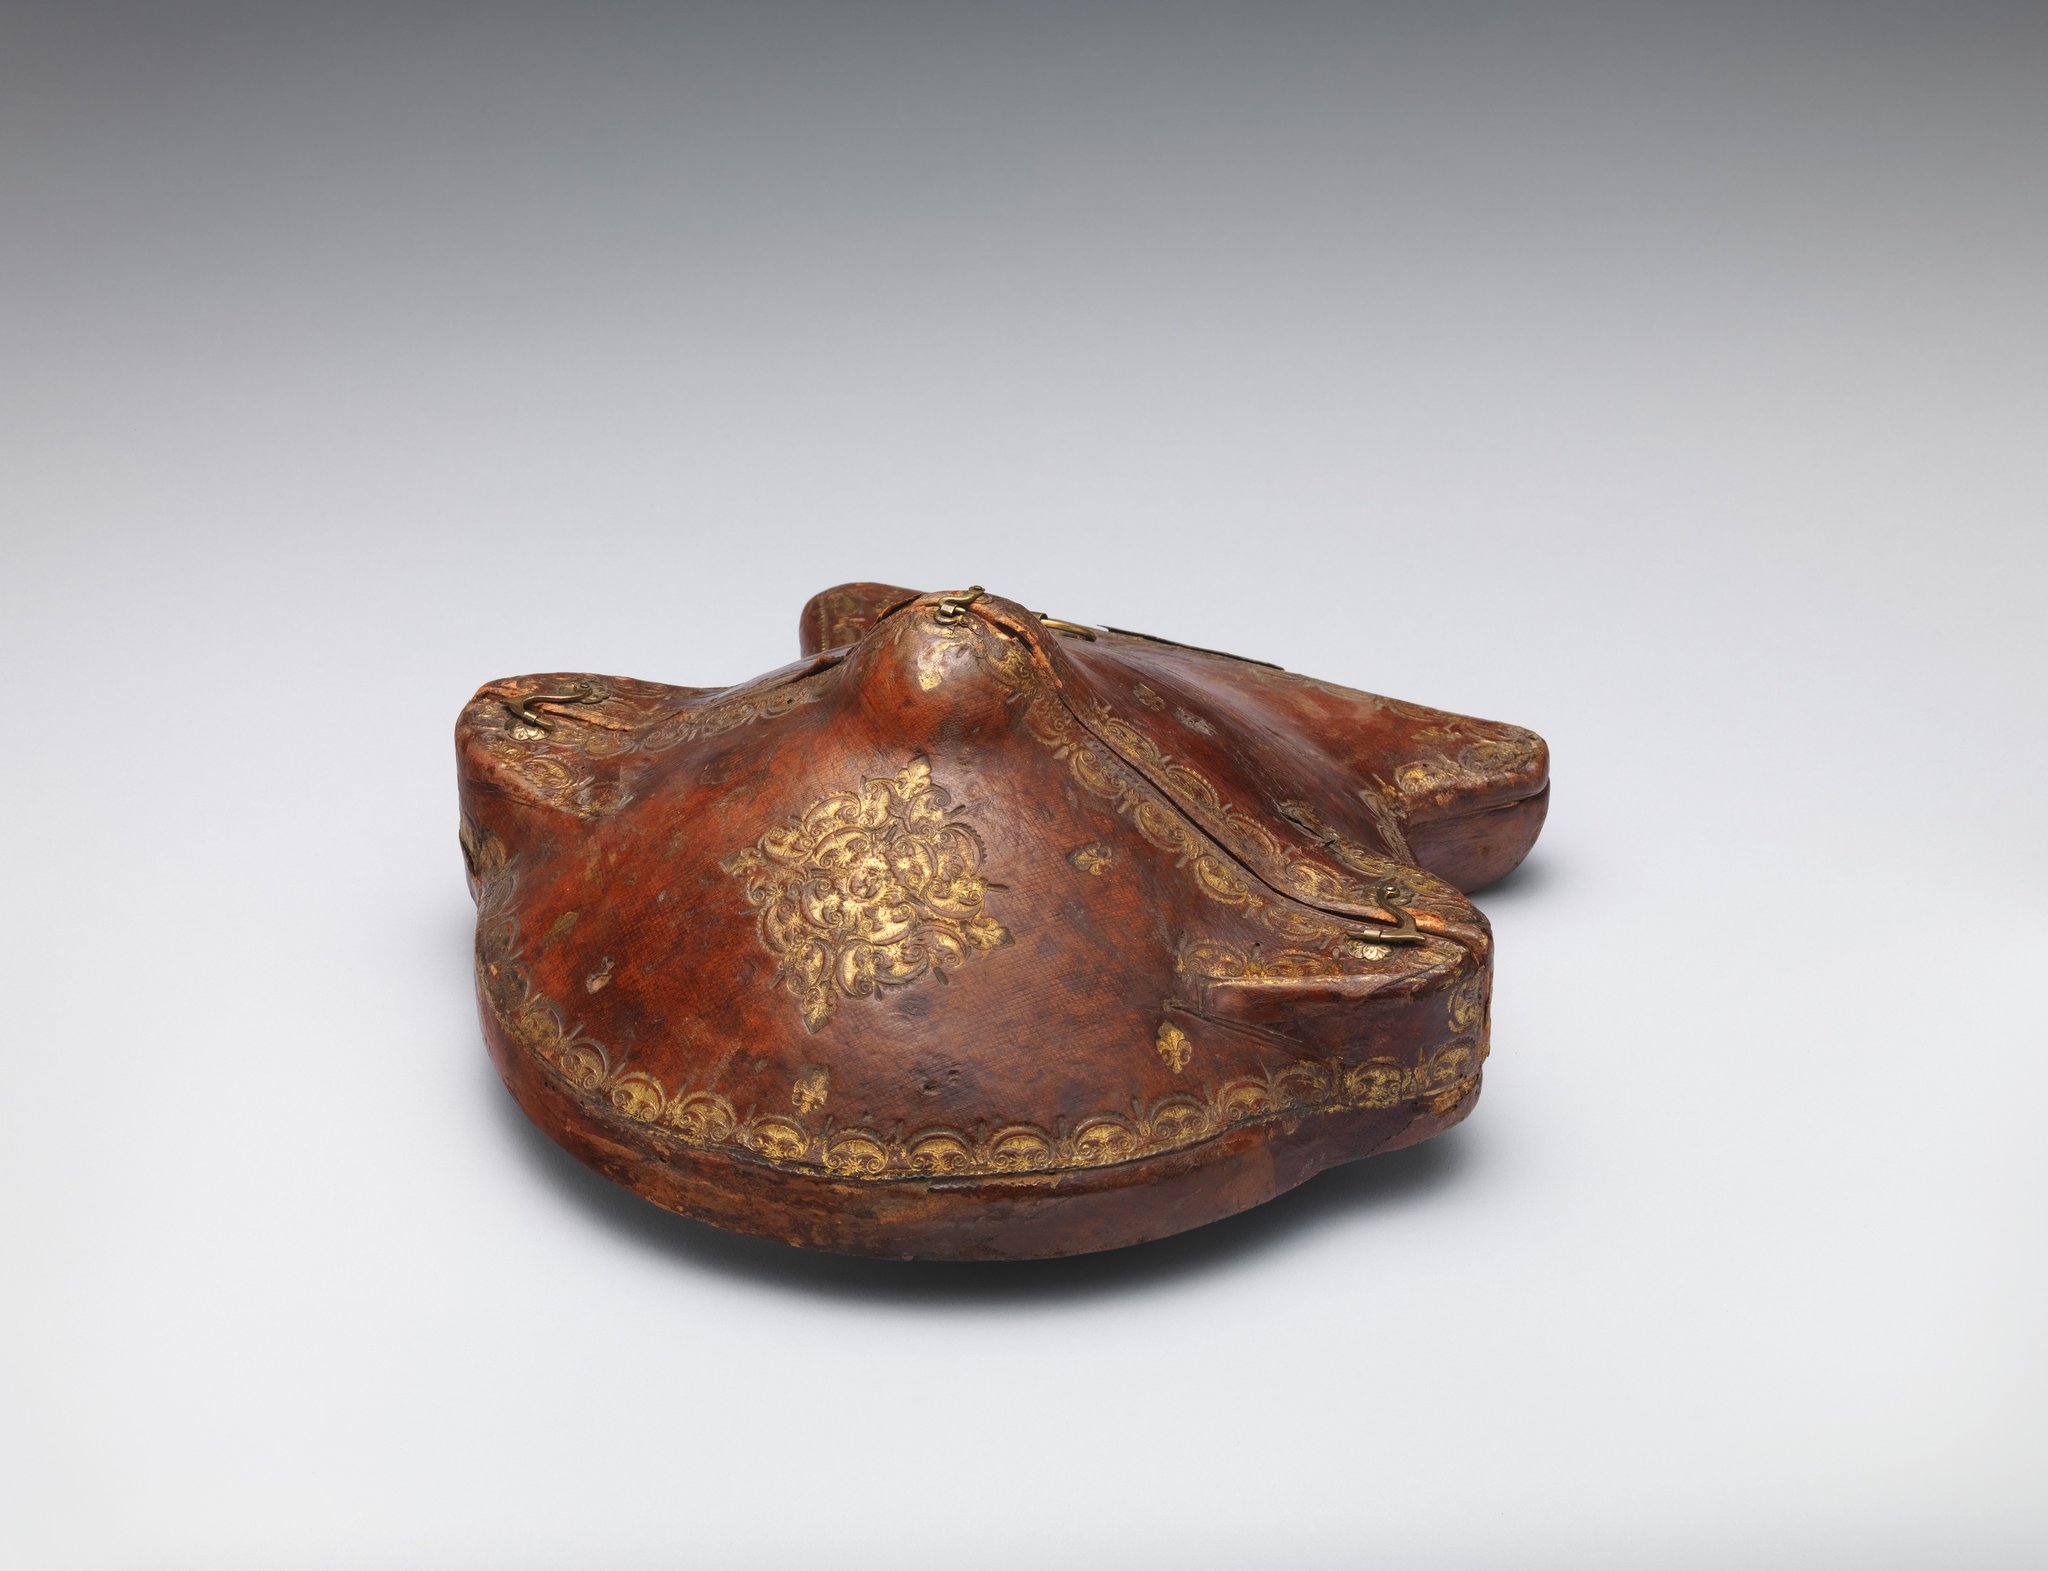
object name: traveling set case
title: Case (part of a traveling set)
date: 1756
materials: brass, gold, leather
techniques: dyeing, tooling